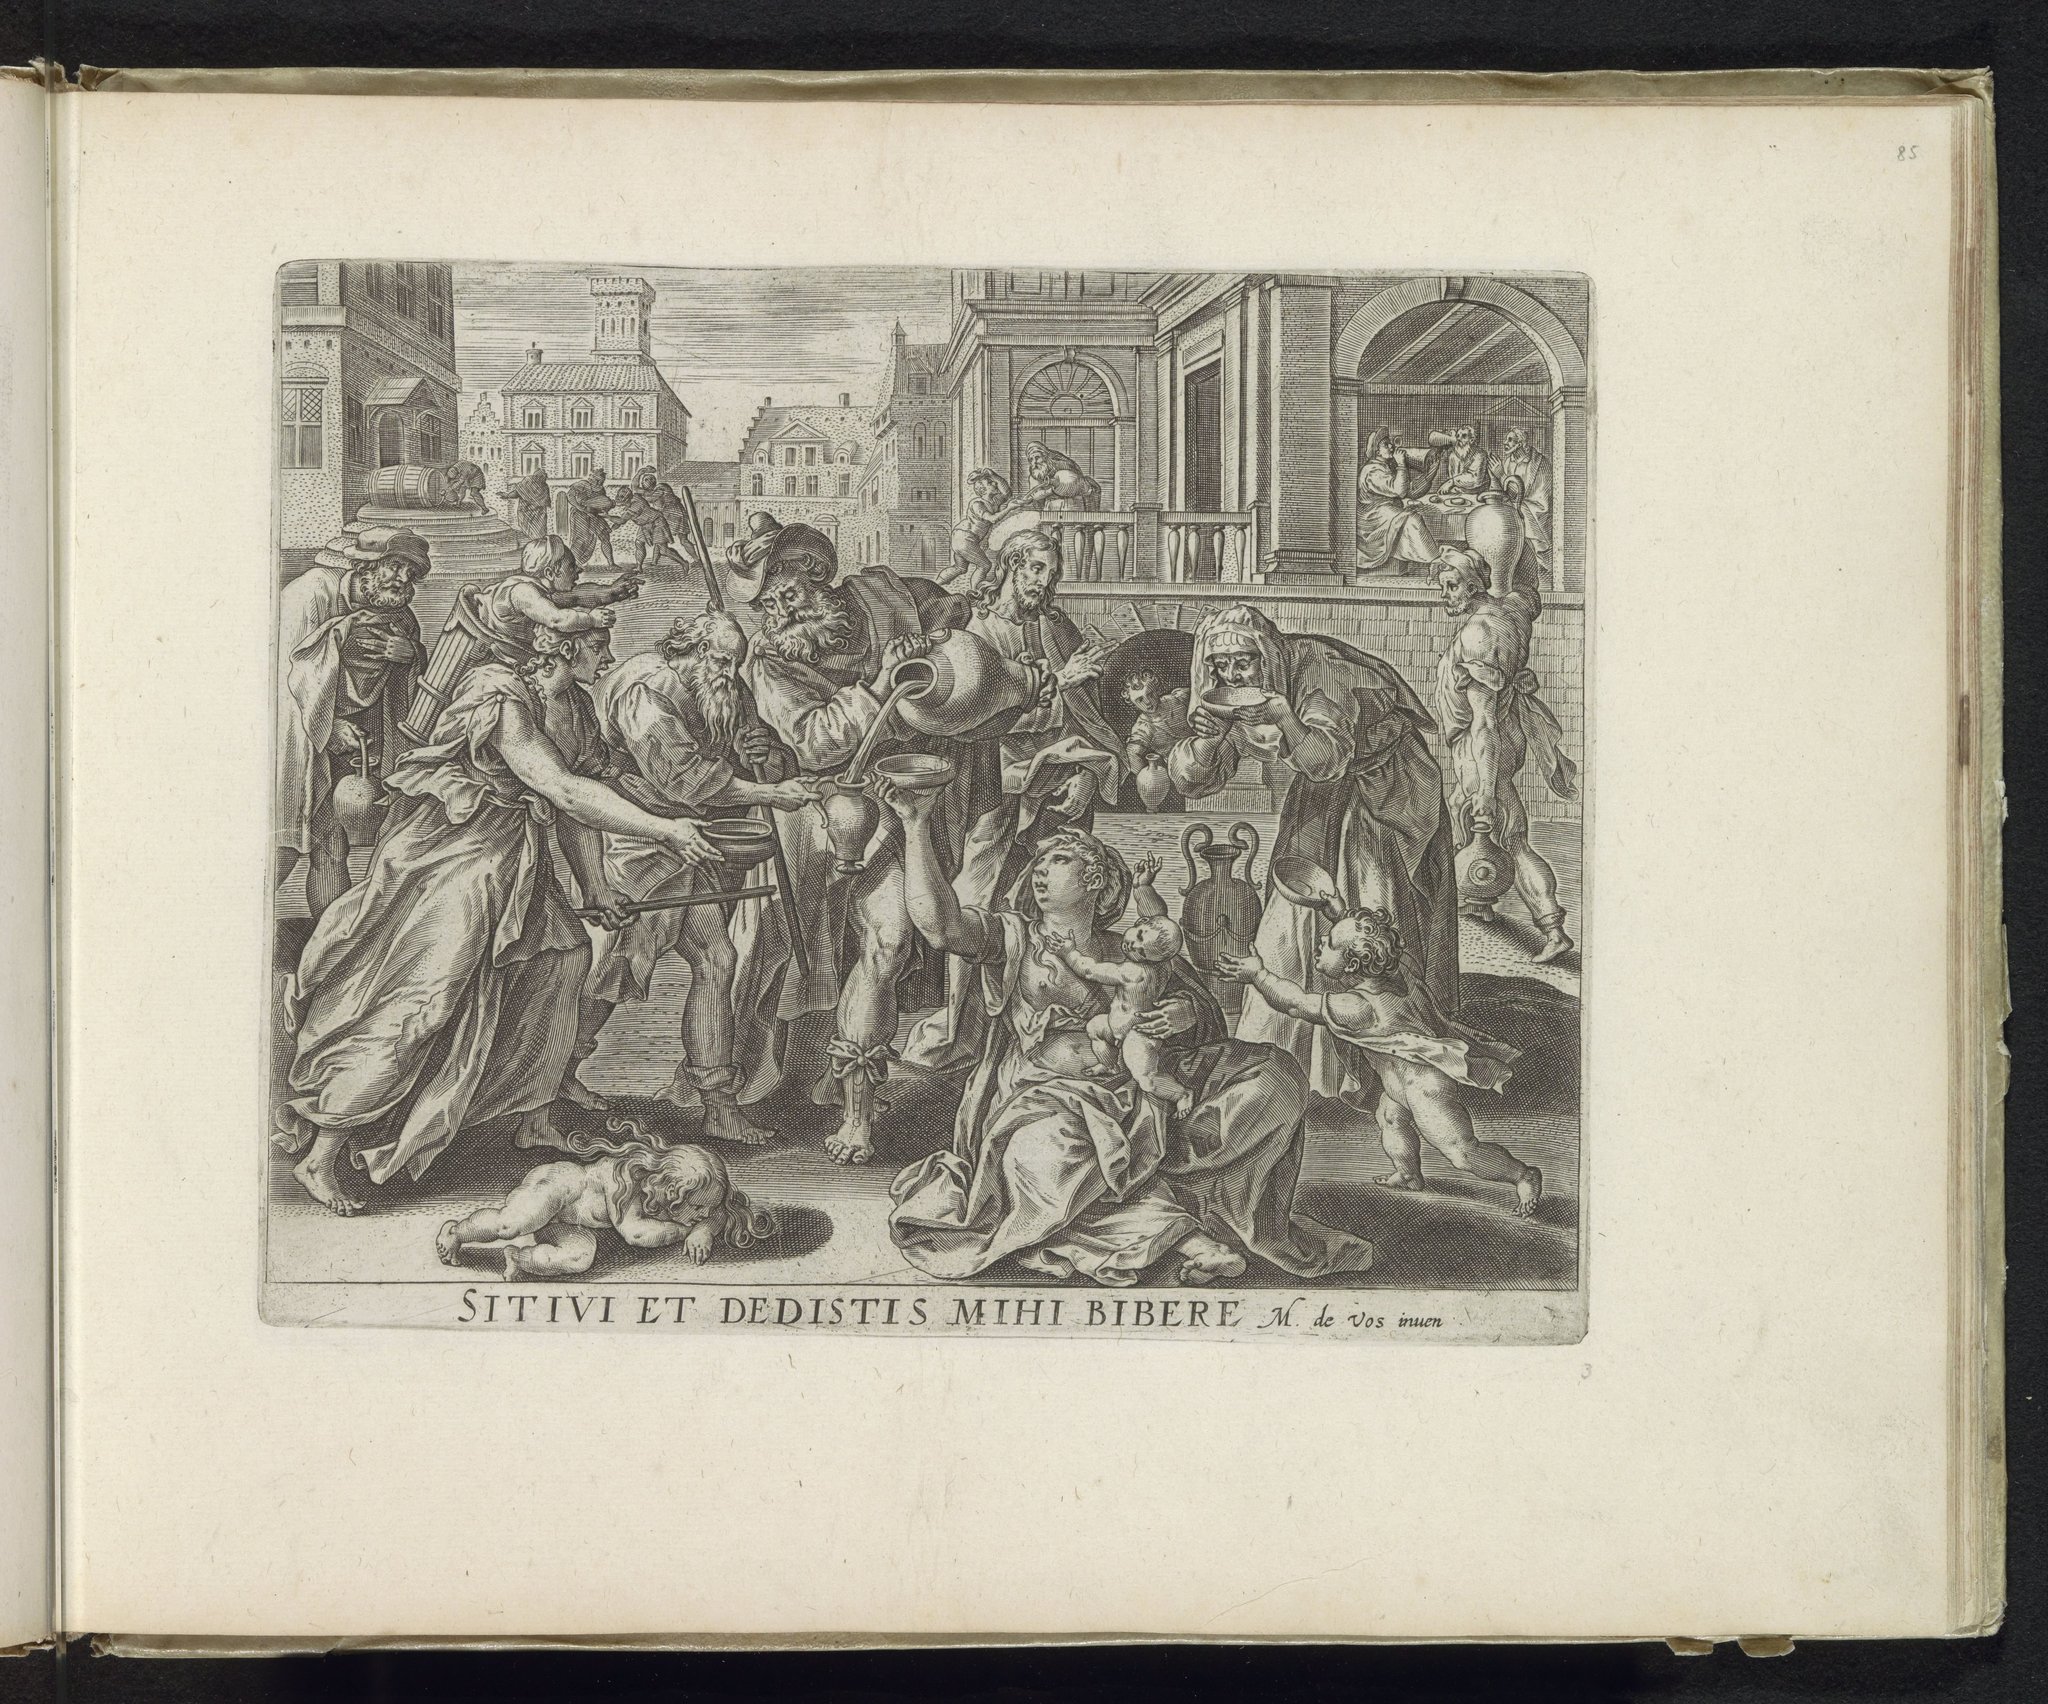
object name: print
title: Dorstigen te drinken geven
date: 1585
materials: paper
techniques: engraving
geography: antwerp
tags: giving the thirsty to drink, 'sitiens potatur' ~ one of the (seven) acts of mercy - vv - christ present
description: Een man schenkt uit een kruik drinken aan de dorstigen, die kommen en kruiken ophouden. Achter de man staat Christus. Op de achtergrond wordt eveneens drinken uitgedeeld. Onder de voorstelling een verwijzing in het Latijn naar de Bijbeltekst. Deze prent maakt deel uit van een album.